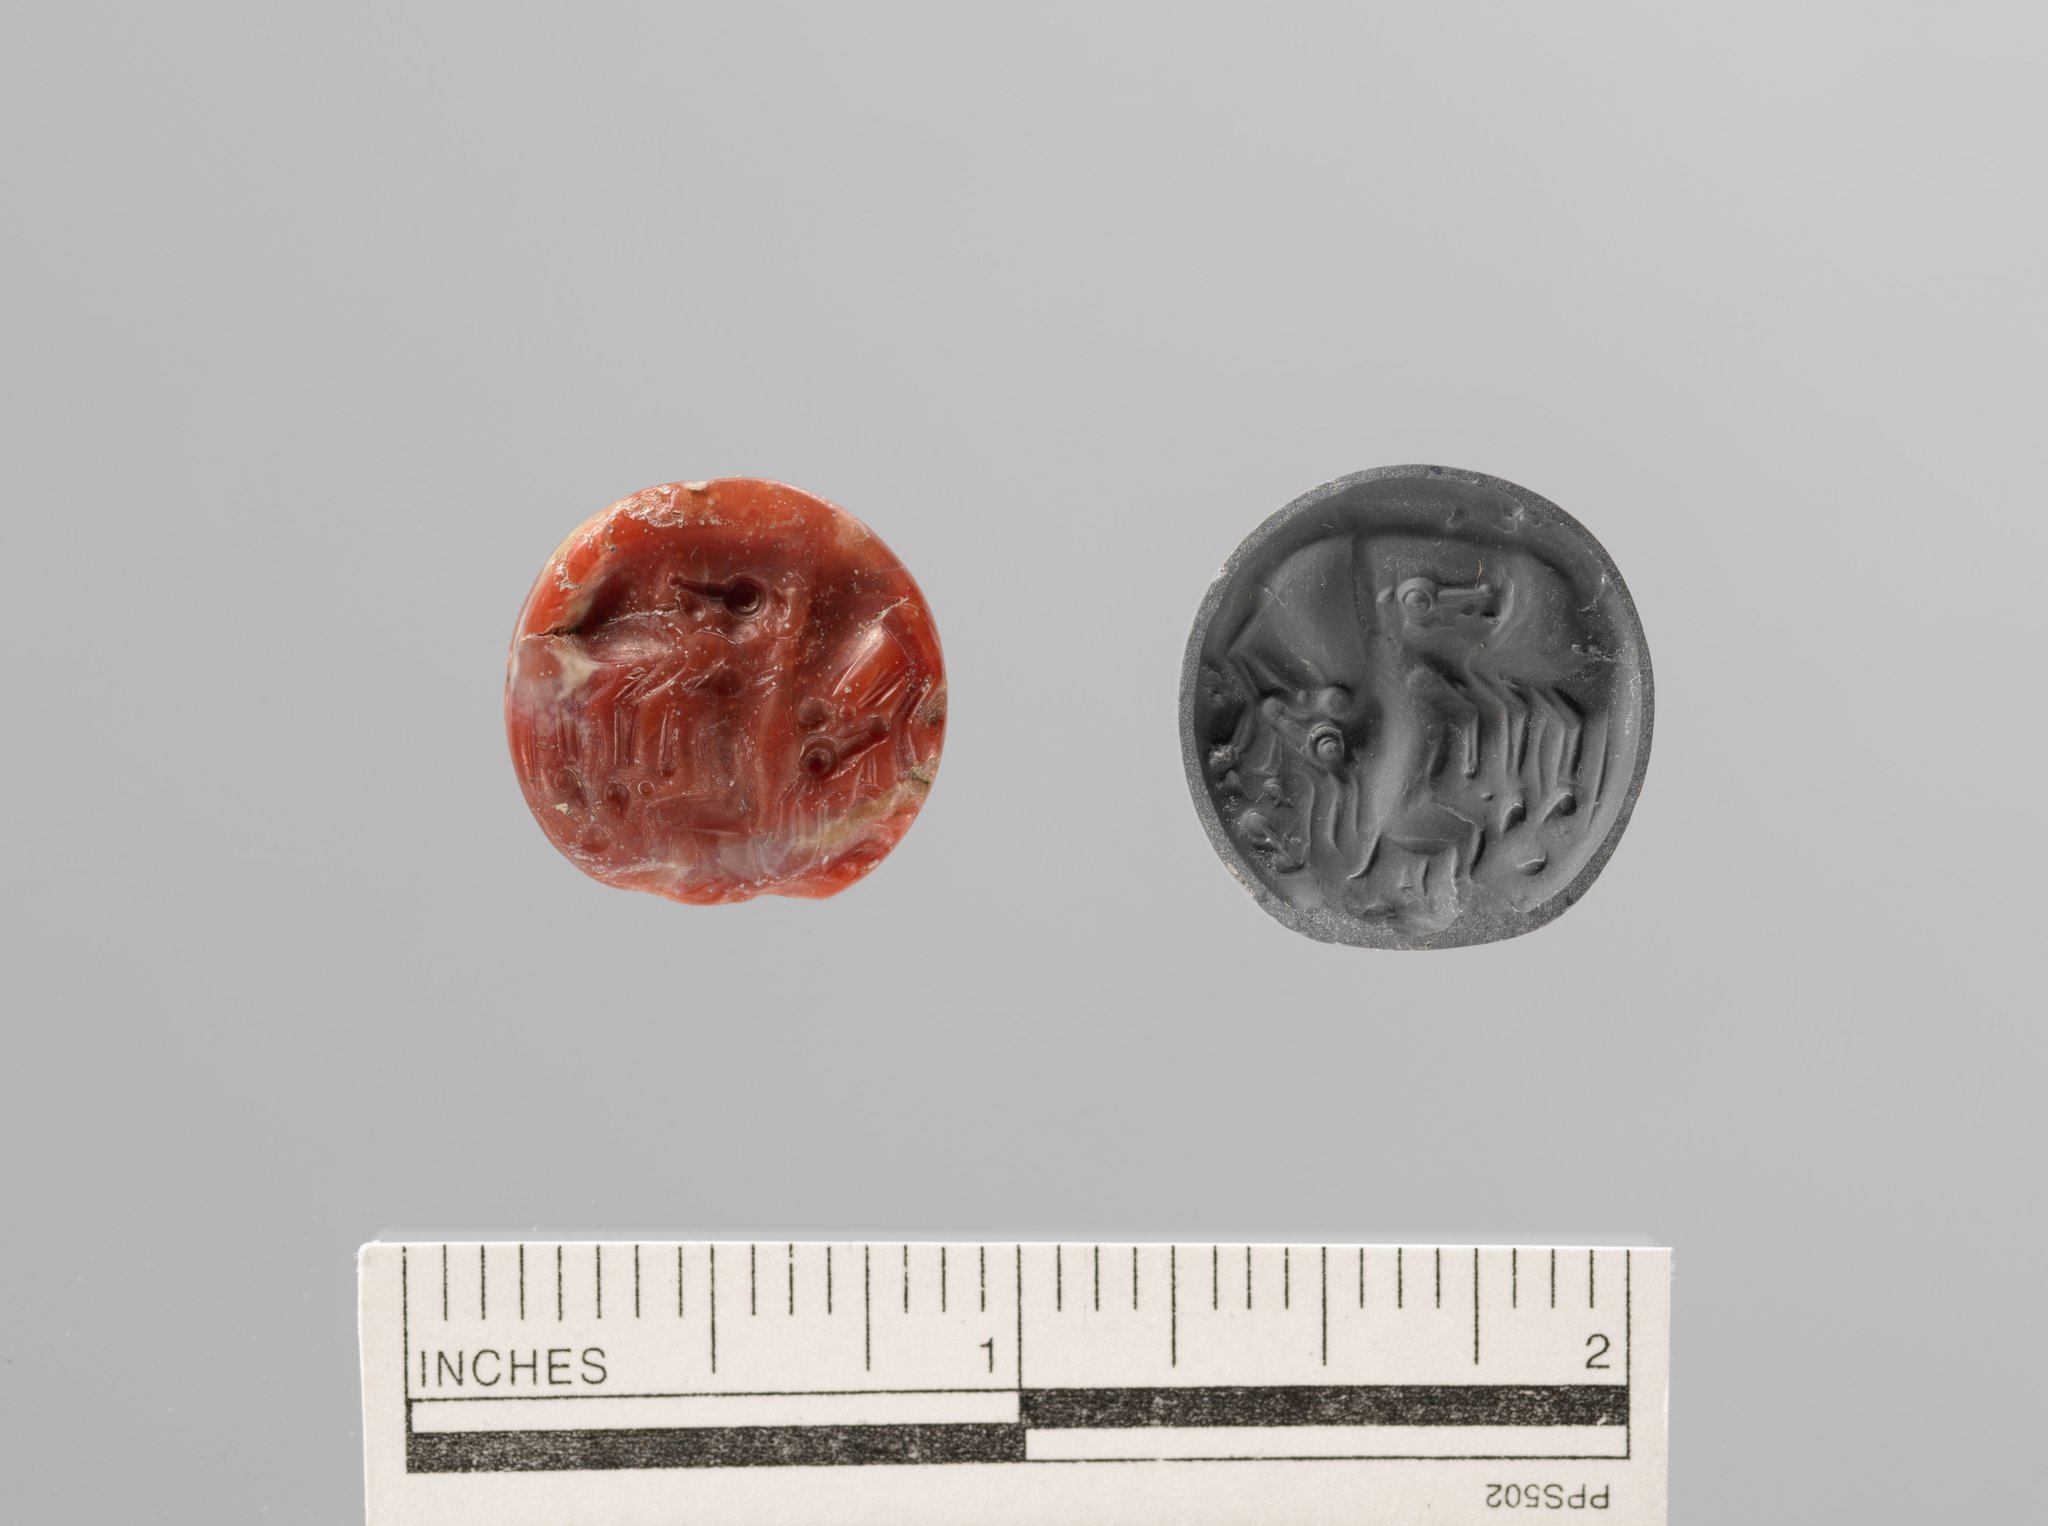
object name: seal, lentoid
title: Carnelian Lentoid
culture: minoan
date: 1400-1375 BCE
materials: gemstone